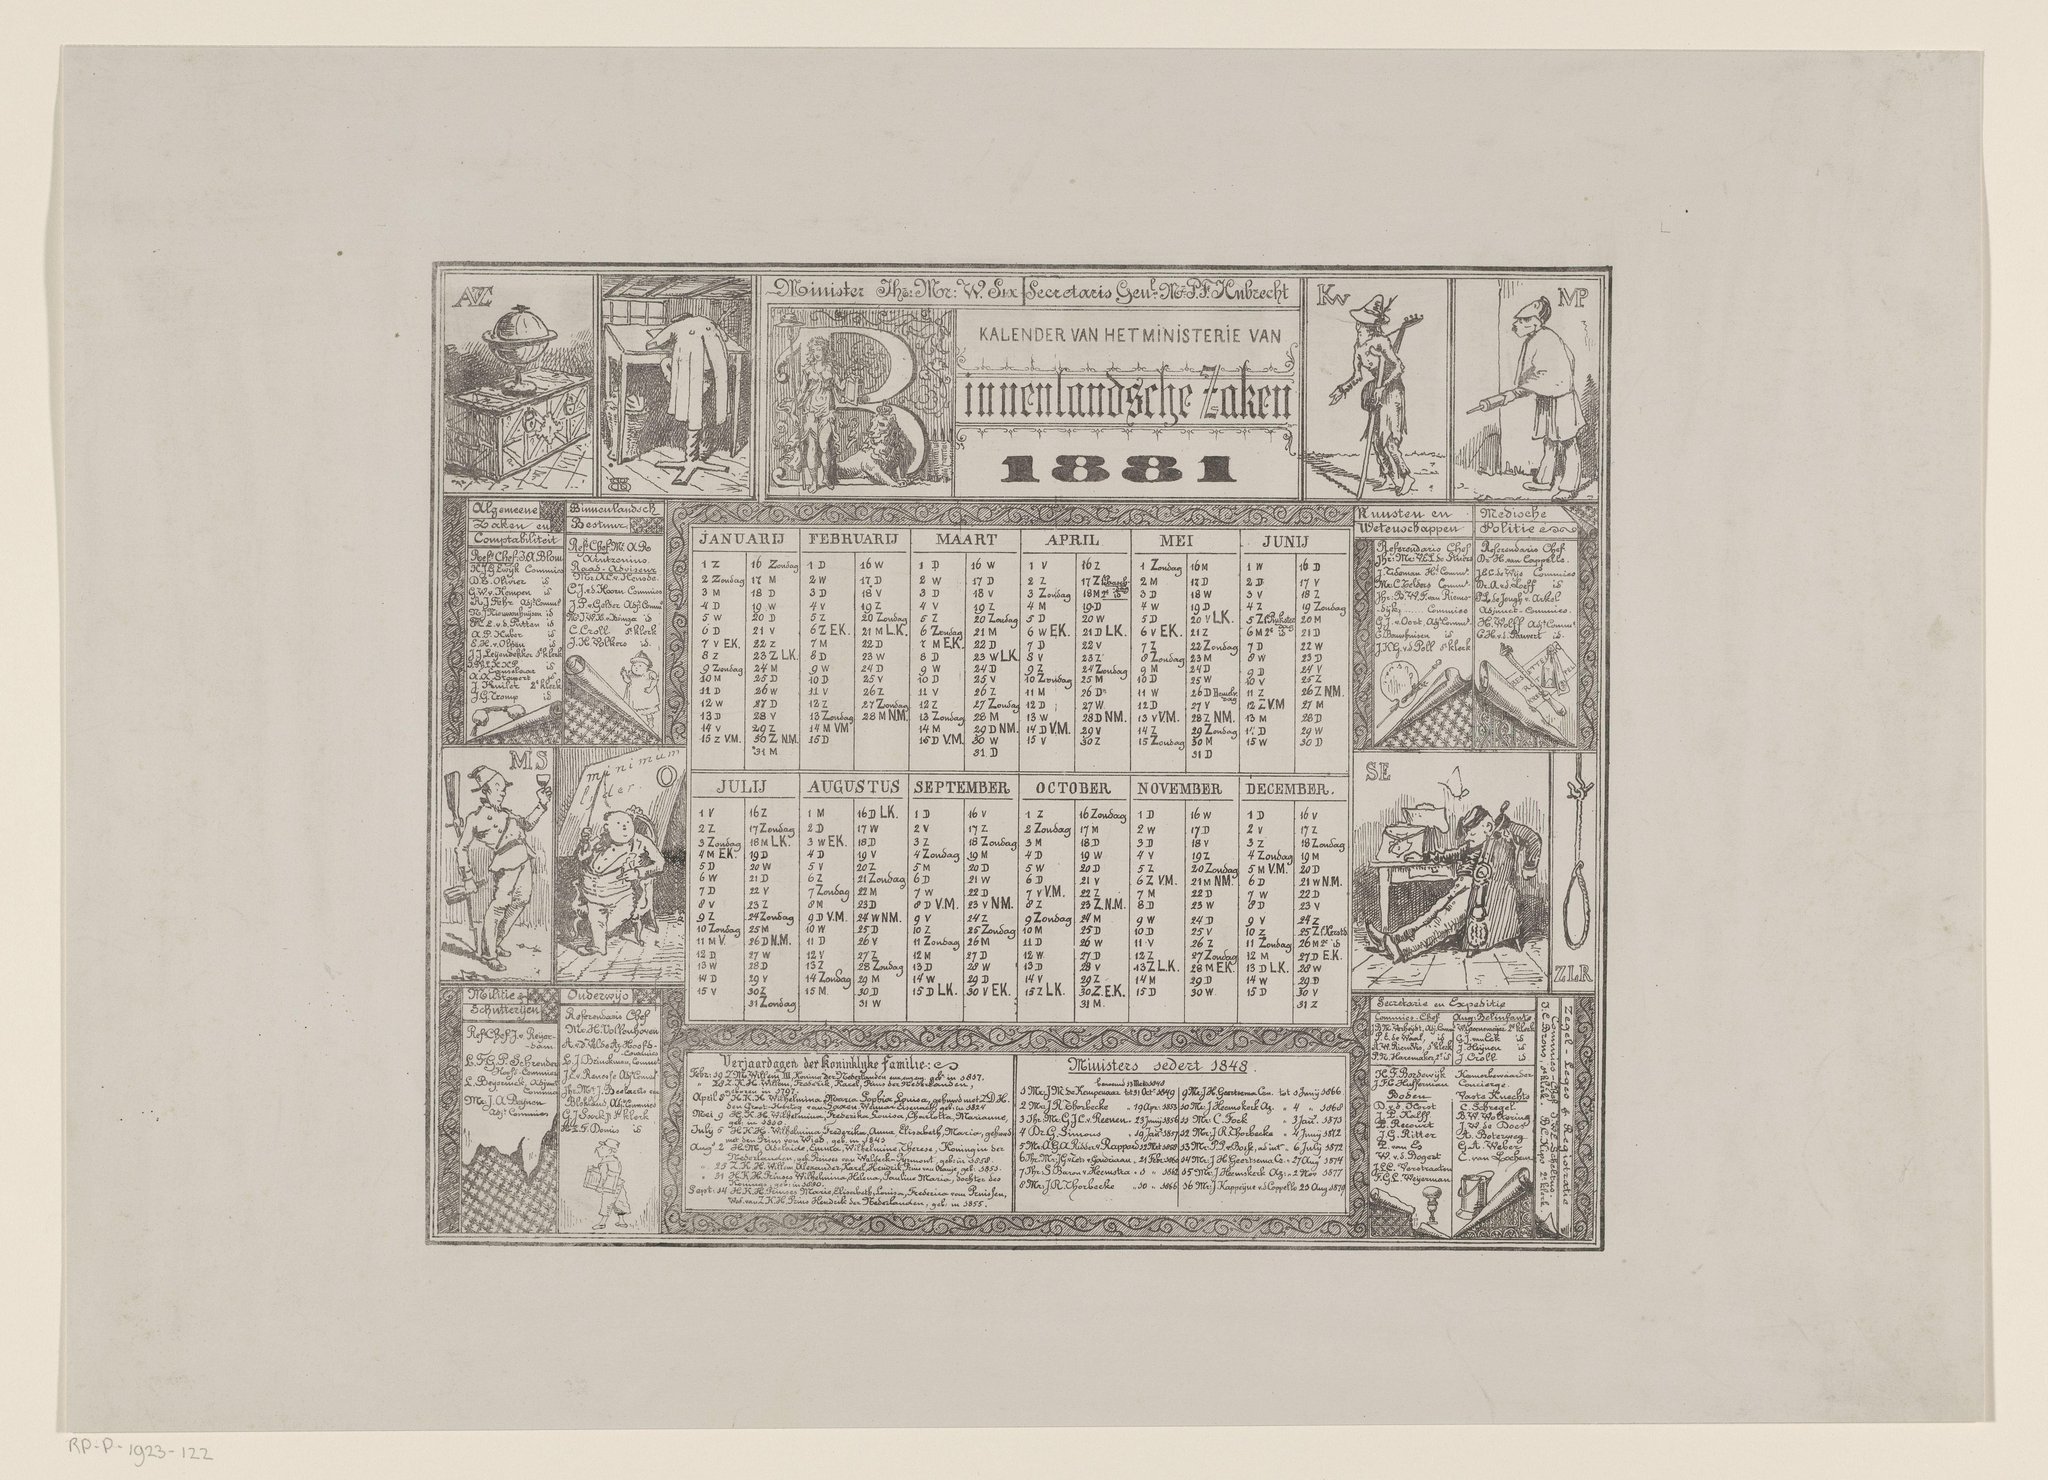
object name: print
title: Kalender van het Ministerie van Binnenlandsche Zaken 1881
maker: Anonymous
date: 1881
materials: paper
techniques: lithograph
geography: netherlands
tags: calendar, almanac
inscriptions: collector's mark: Lugt 2233, collector's mark: Lugt 2228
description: Kalender van het Ministerie van Binnenlandse zaken met karikaturen van de structuur van het departement. Van links boven naar rechts onder in beeld: Algemene Zaken en Comptabiliteit, het Binnenlands Bestuur, Kunsten en Wetenschappen, de Medische Politie, de Militie Schutterijen, Onderwijs, Secretaris en Expeditie en de Zegel- Leges en Registratie.